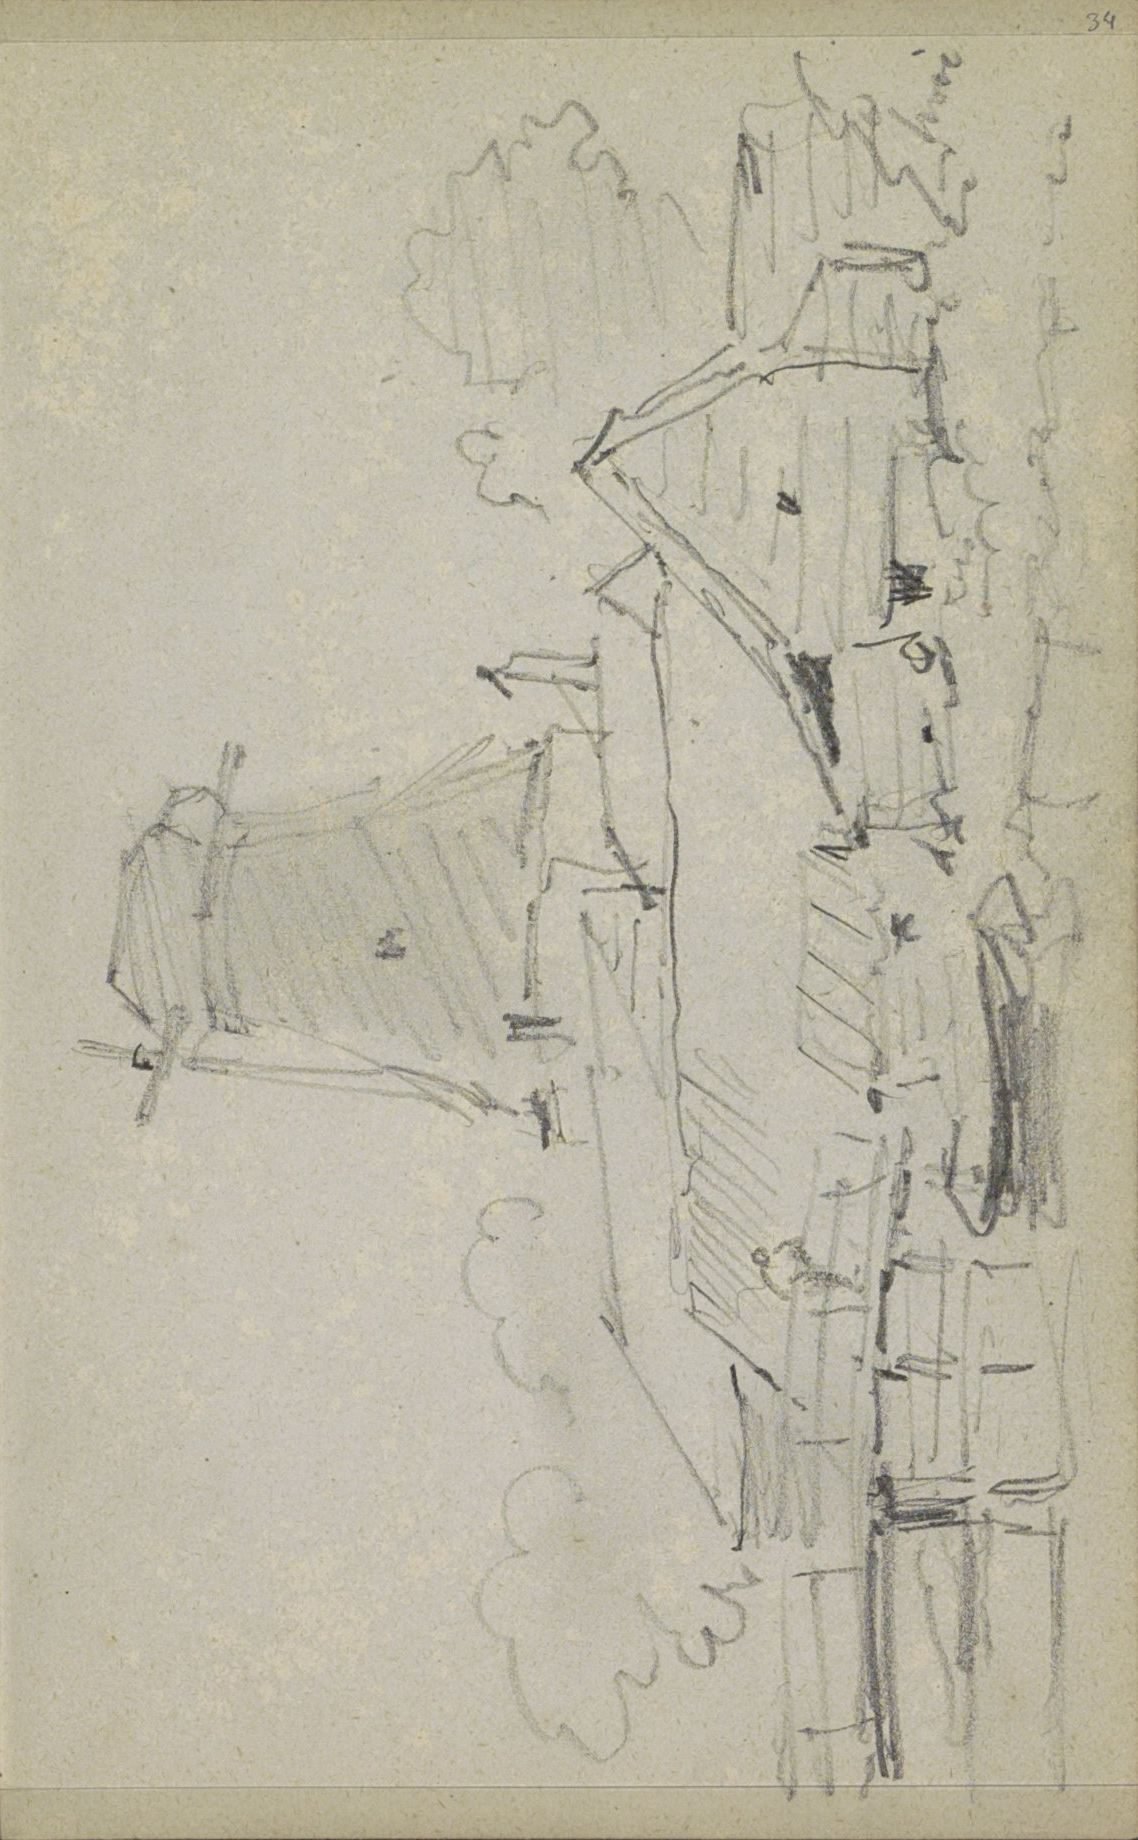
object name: sketchbook leaf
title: Molen aan het water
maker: adrianus eversen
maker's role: draughtsman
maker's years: 1818-1897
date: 1828-1897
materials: paper, pencil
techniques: stumping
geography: netherlands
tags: landscapes with waters, waterscapes, seascapes (in the temperate zone), windmill in landscape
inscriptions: annotation: ‘hooi’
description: Gezicht op een molen aan het water. Vooraan een figuur op een brug. Bij de brug een boot. Blad 34 recto uit een schetsboek met 58 bladen.